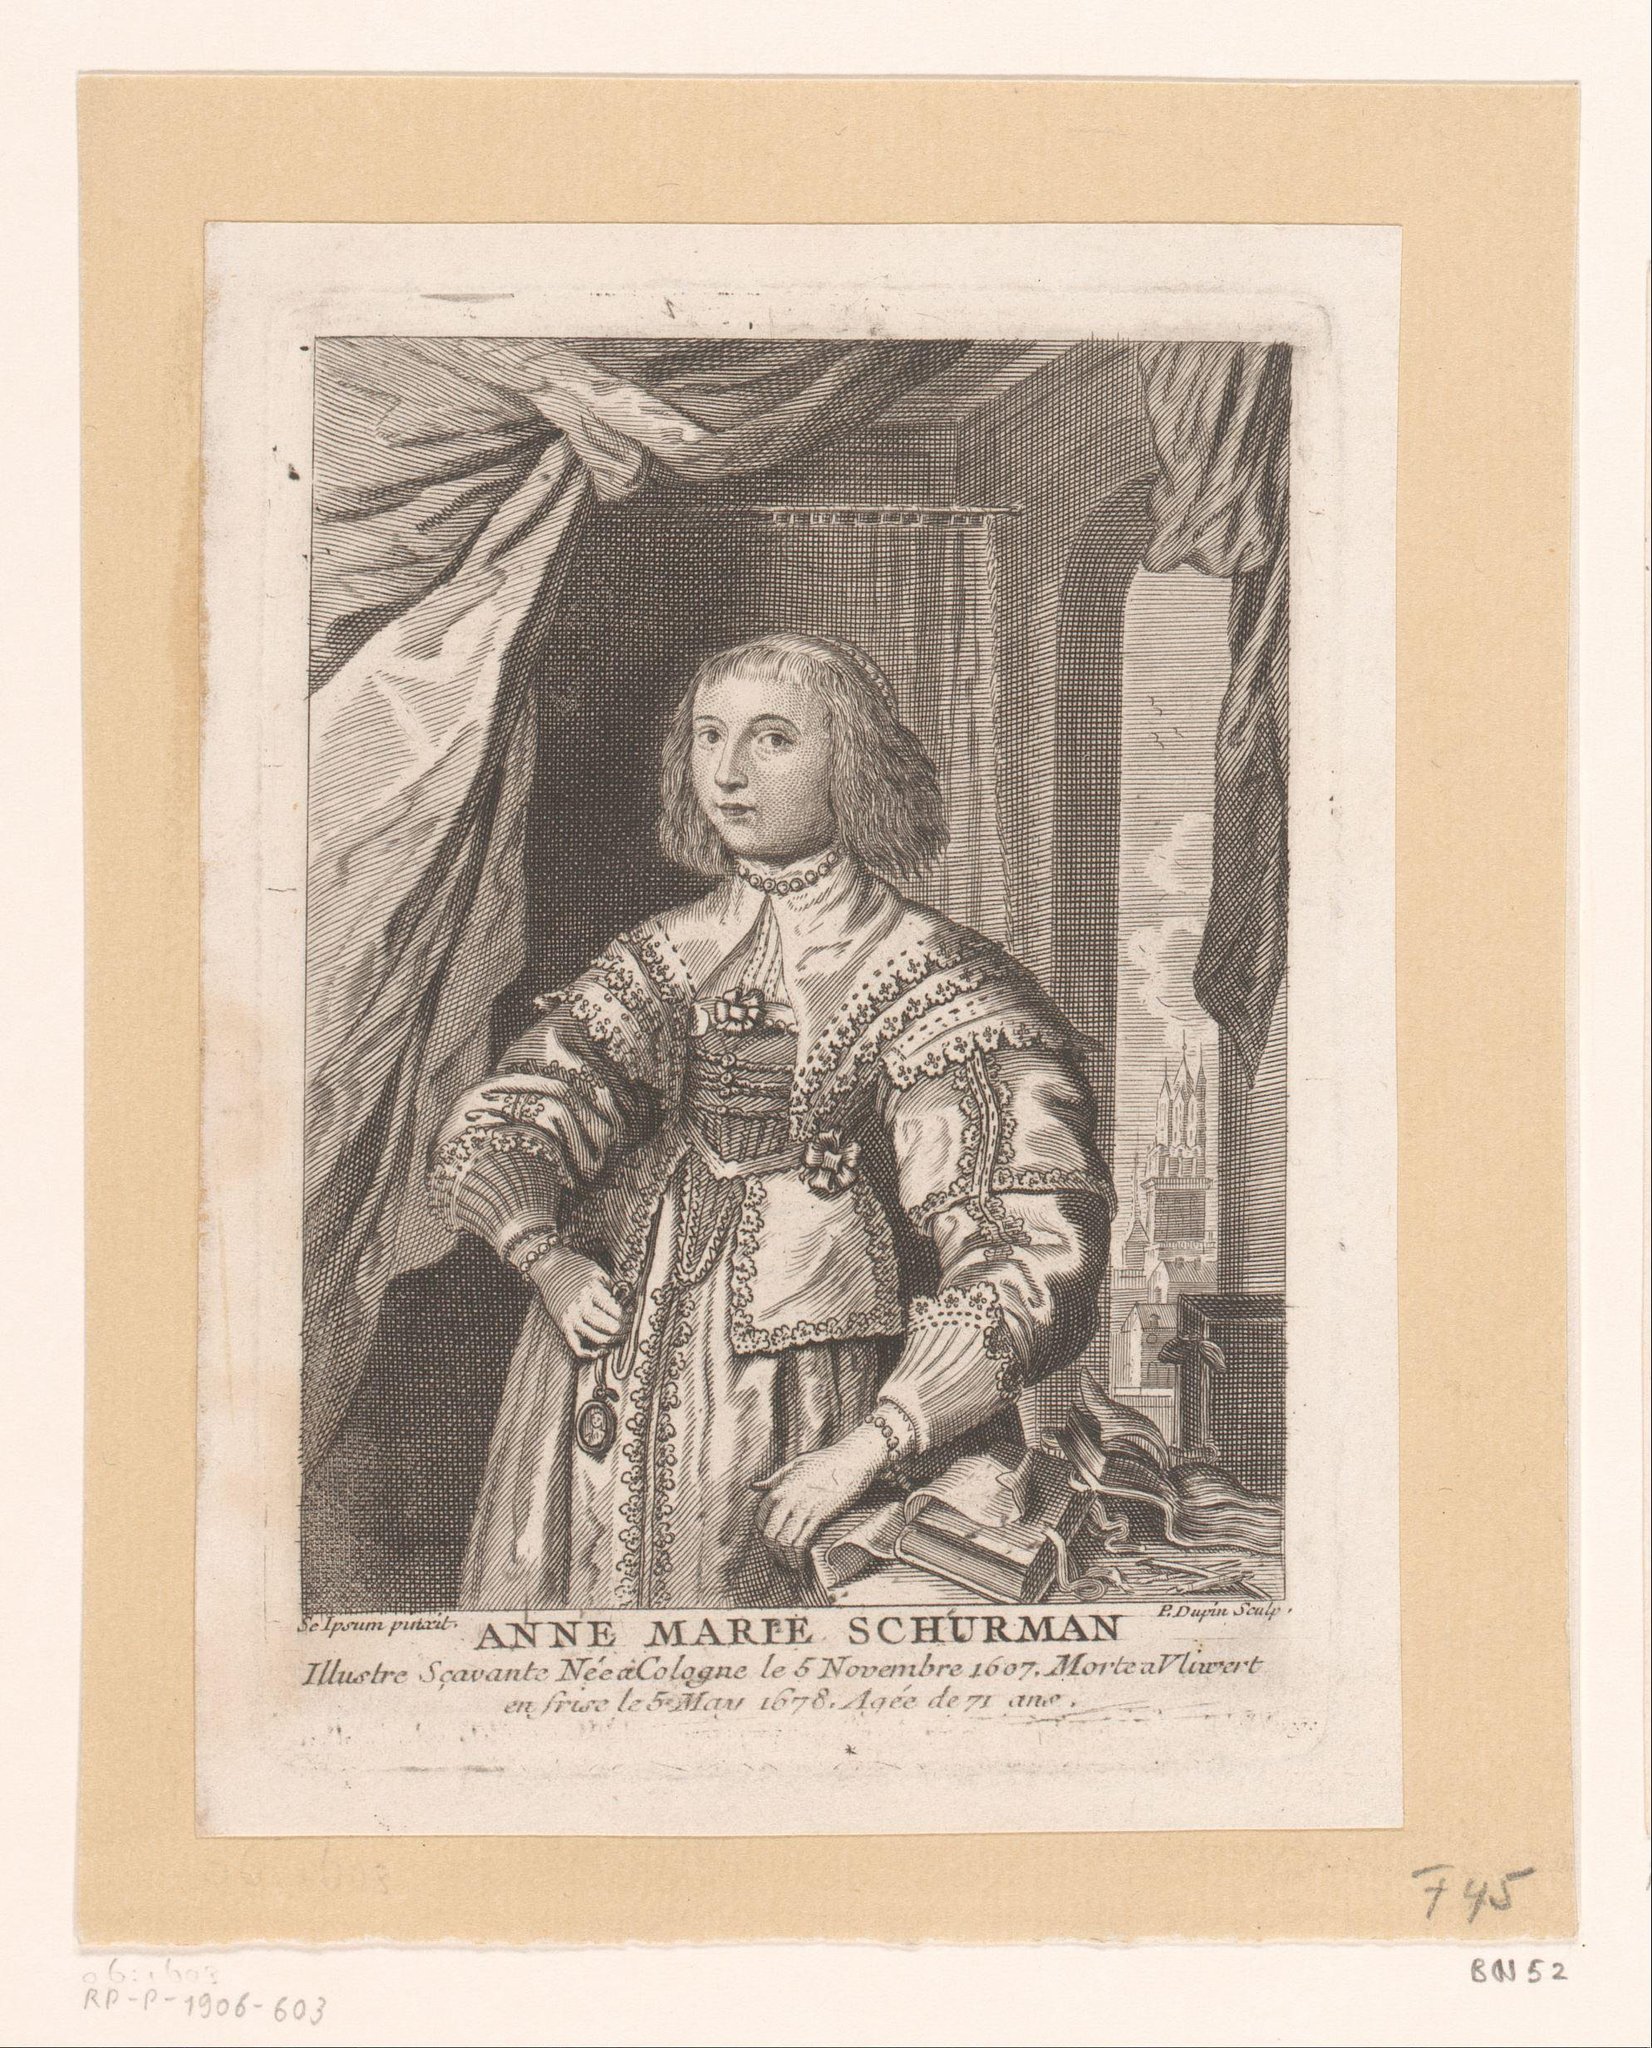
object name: print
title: Anne Marie Schurman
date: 1700-1751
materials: paper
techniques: engraving, etching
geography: france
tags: cologne, print maker, draughtsman, anna maria van schurman, theologian, historical persons - bb - woman, scholar, philosopher, portrait, self-portrait of artist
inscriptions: collector's mark: Lugt 2228